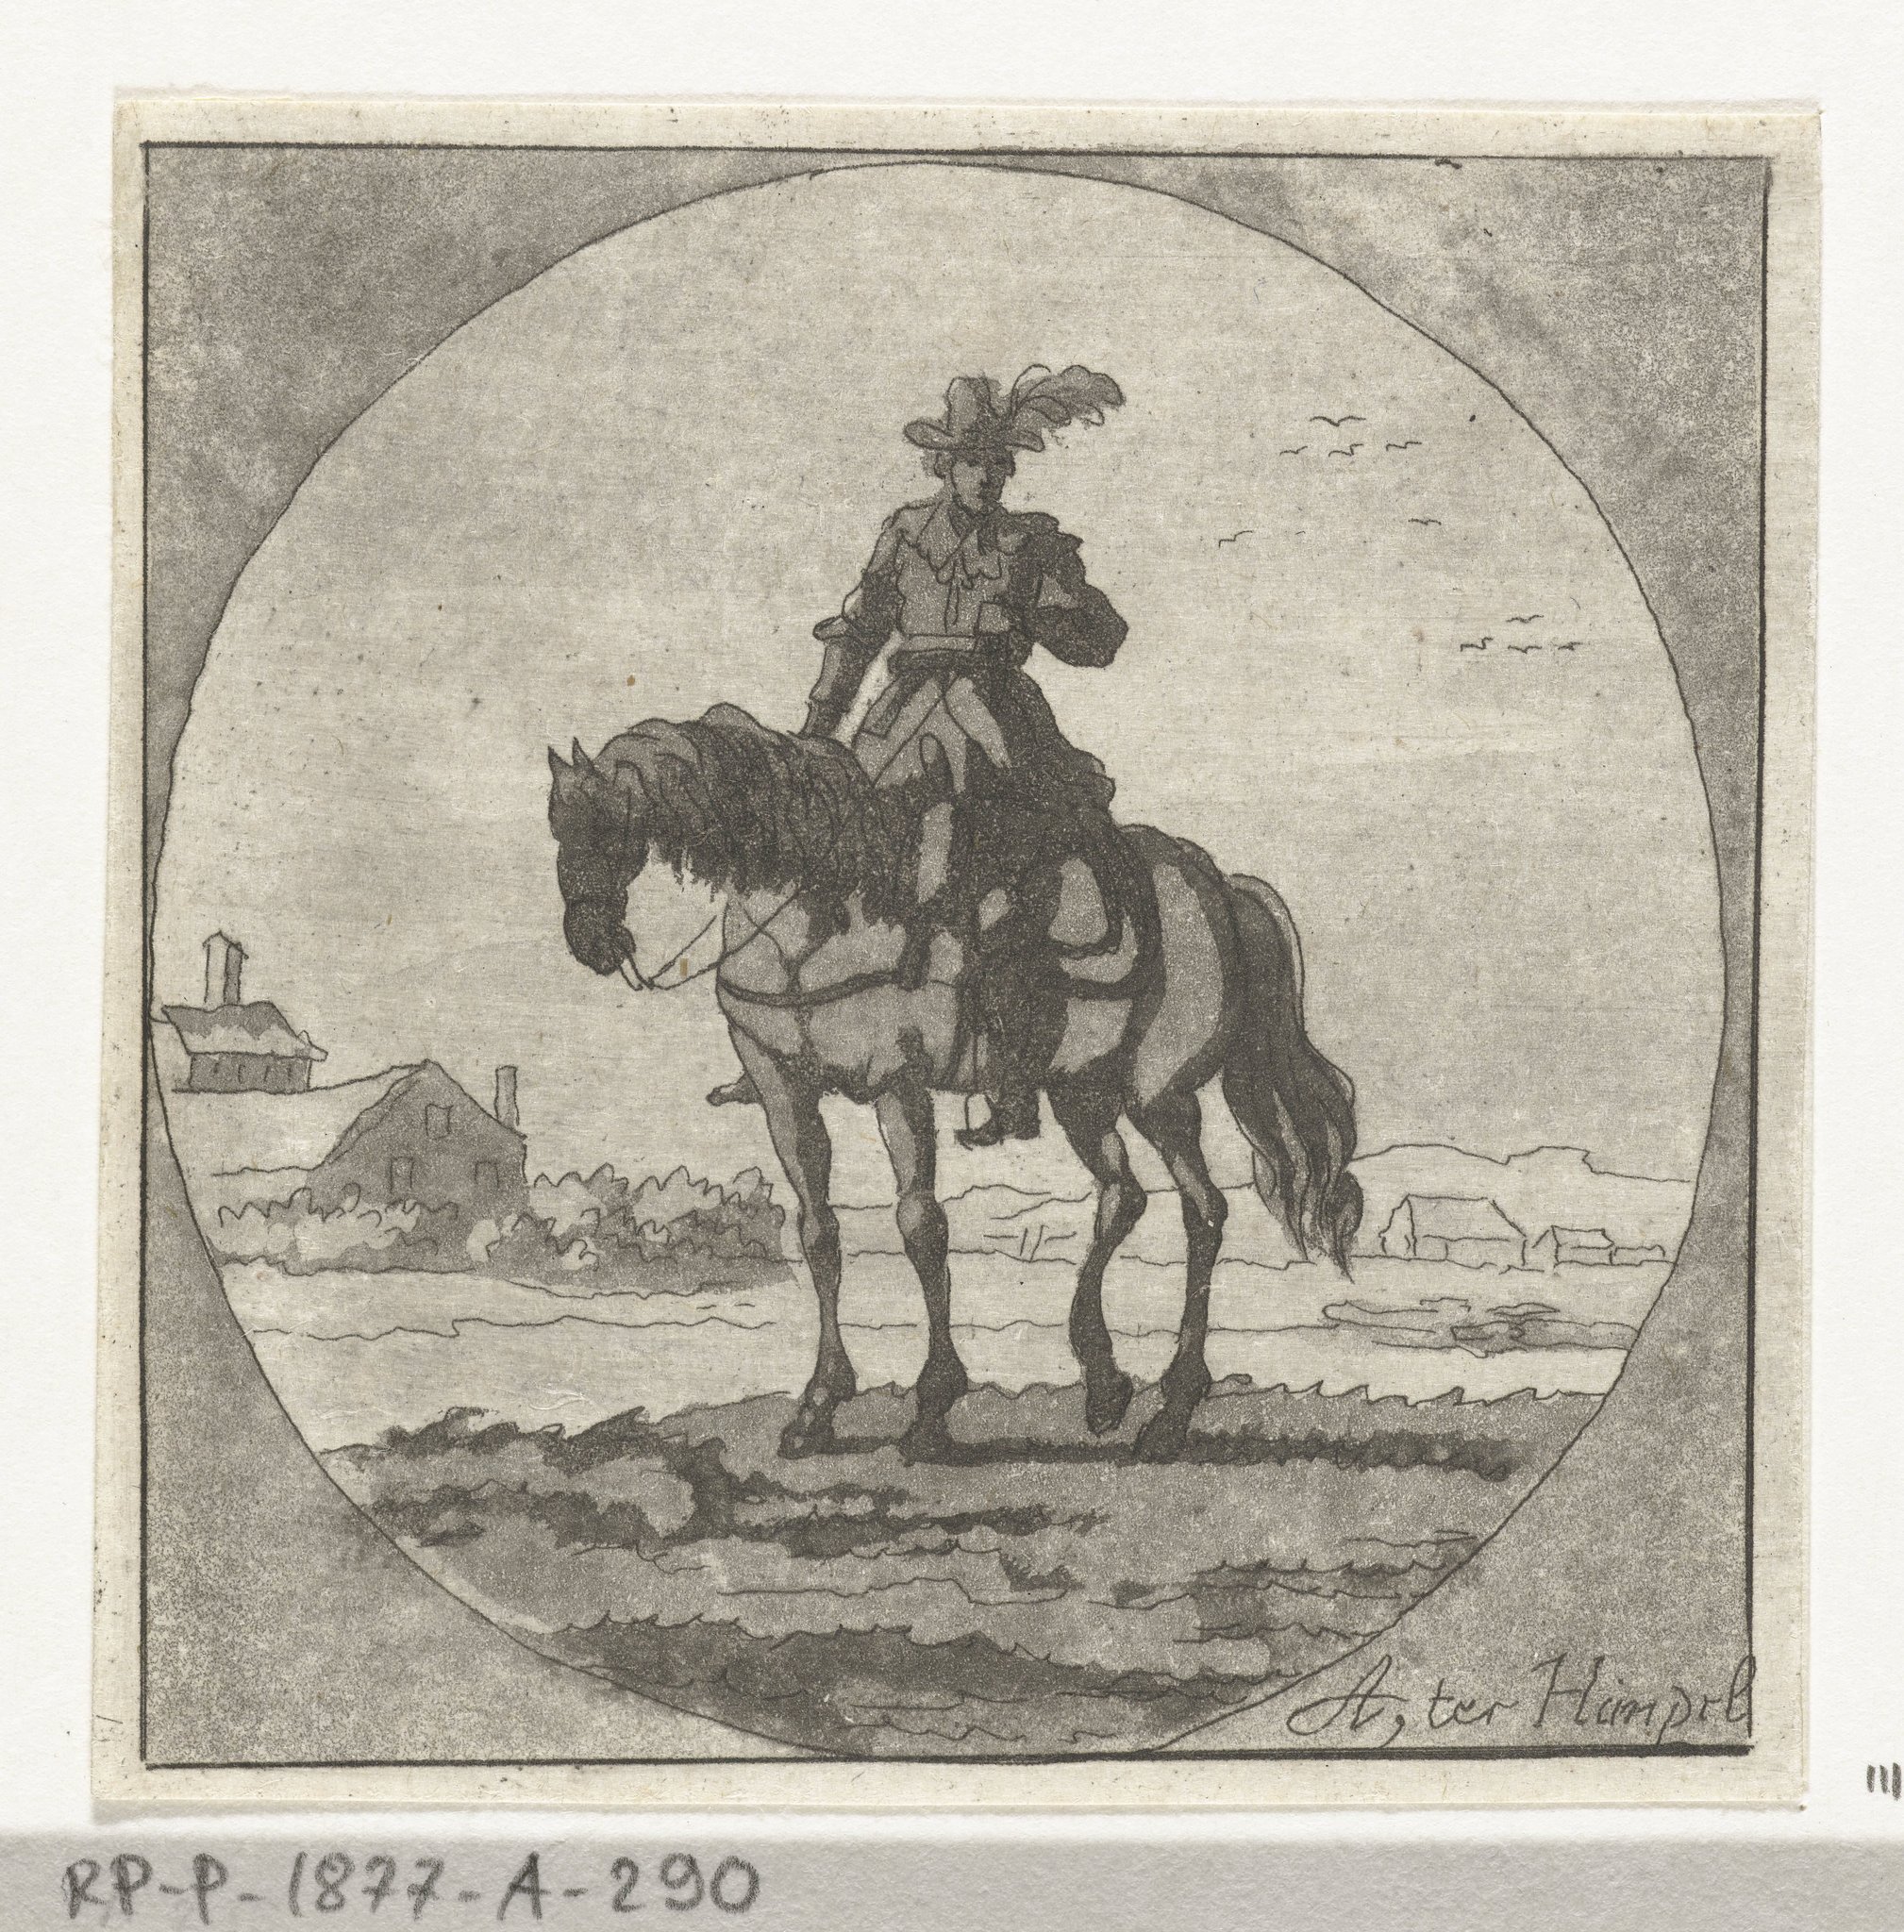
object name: print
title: Ruiter op staand paard in medaillon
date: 1778-1838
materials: paper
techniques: aquatint, etching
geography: netherlands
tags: riding a horse, ass, or mule; rider, horseman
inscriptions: collector's mark: Lugt 2228